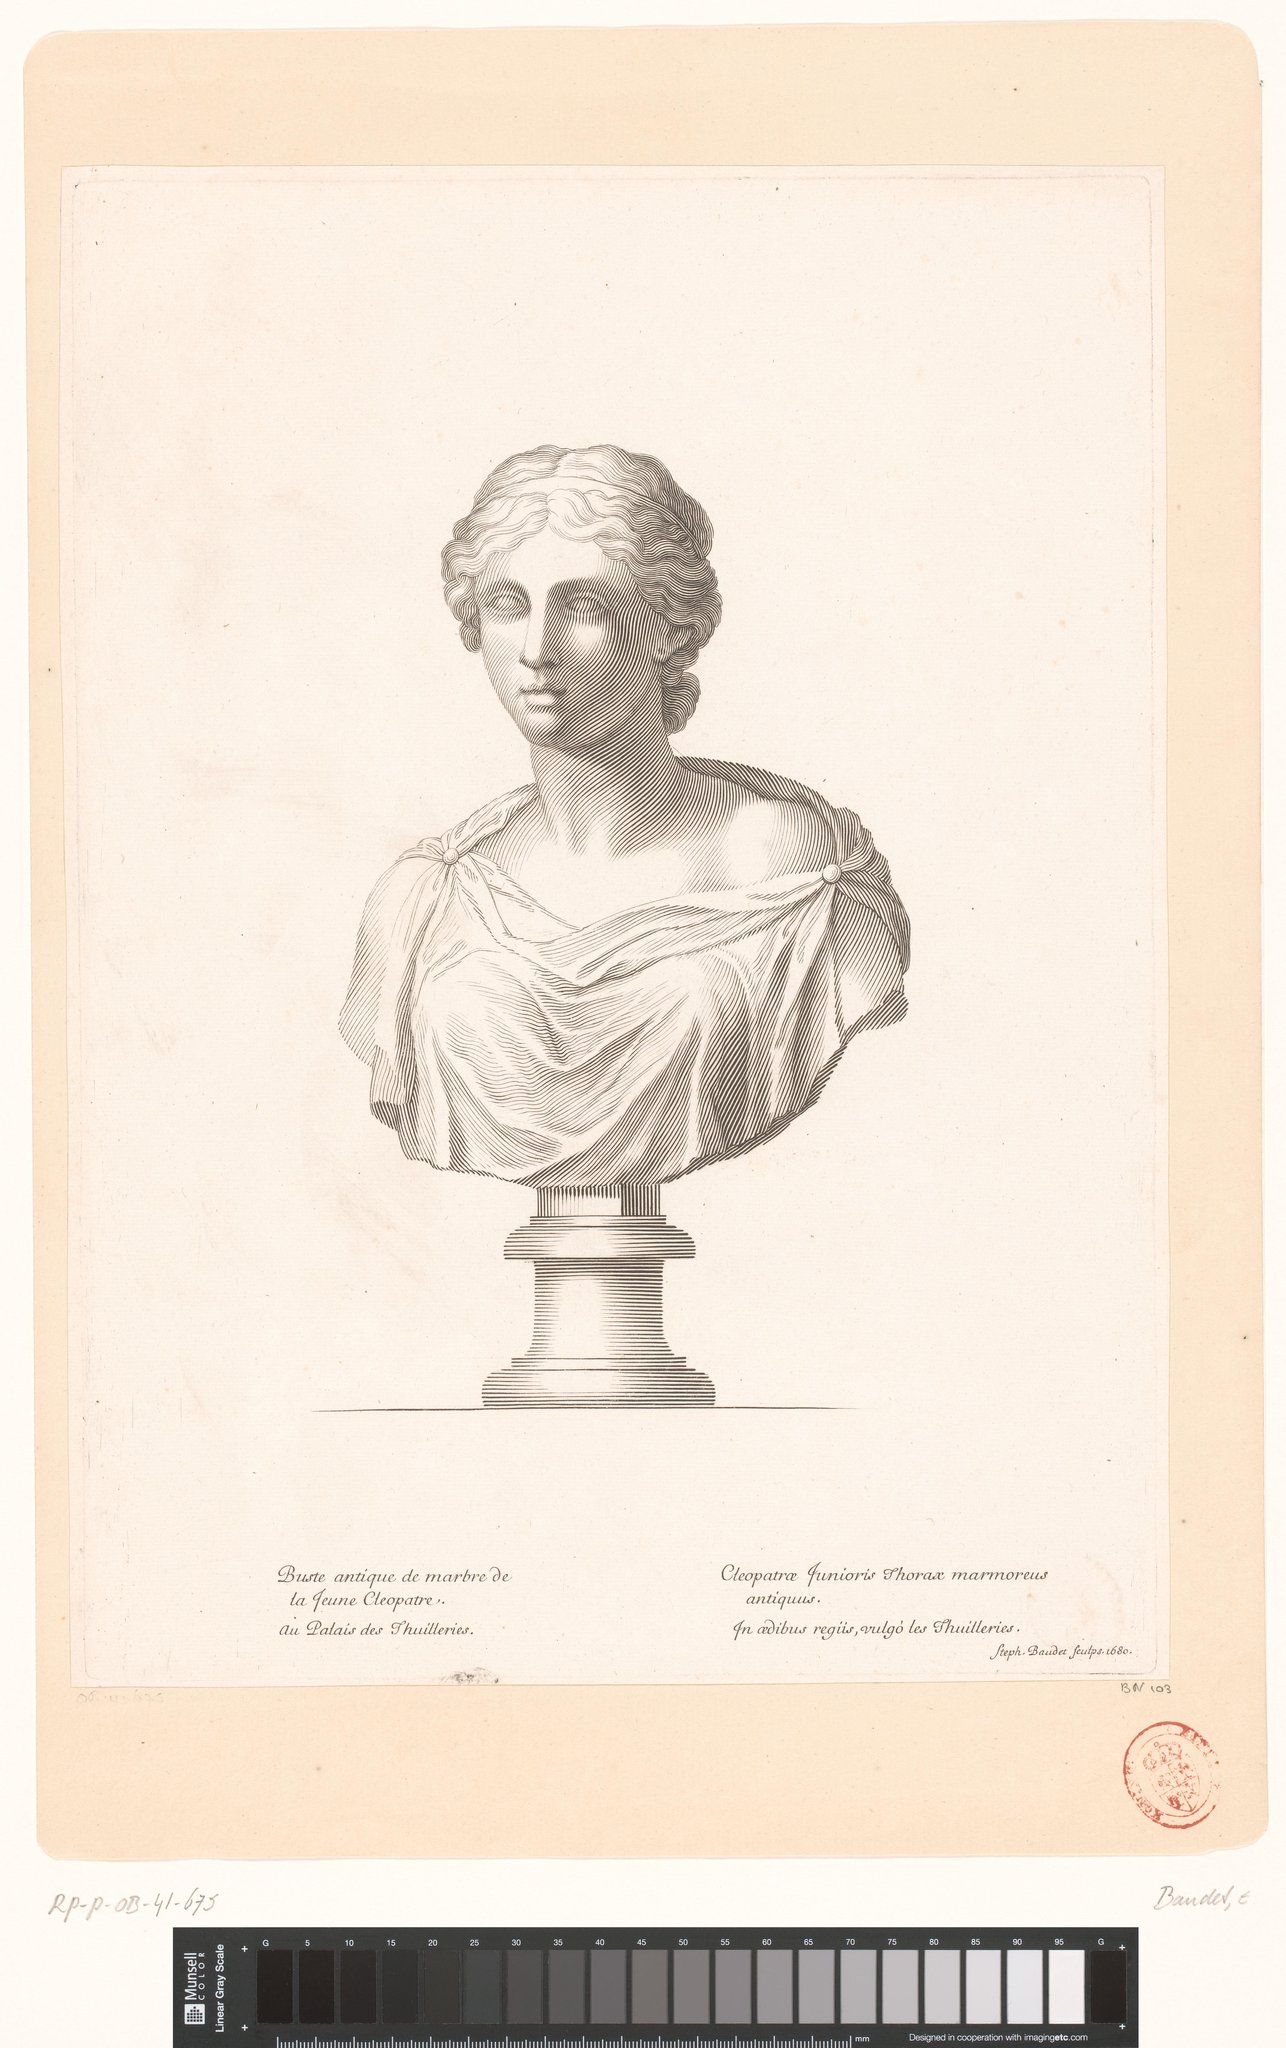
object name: print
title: Antieke beelden uit de Tuilerieën en het Louvre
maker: etienne baudet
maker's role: print maker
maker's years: 1638-1711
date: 1680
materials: paper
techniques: engraving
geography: france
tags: piece of sculpture, reproduction of a piece of sculpture, chest, bust - aa - female human figure, tuileries palace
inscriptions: collector's mark: Lugt 240